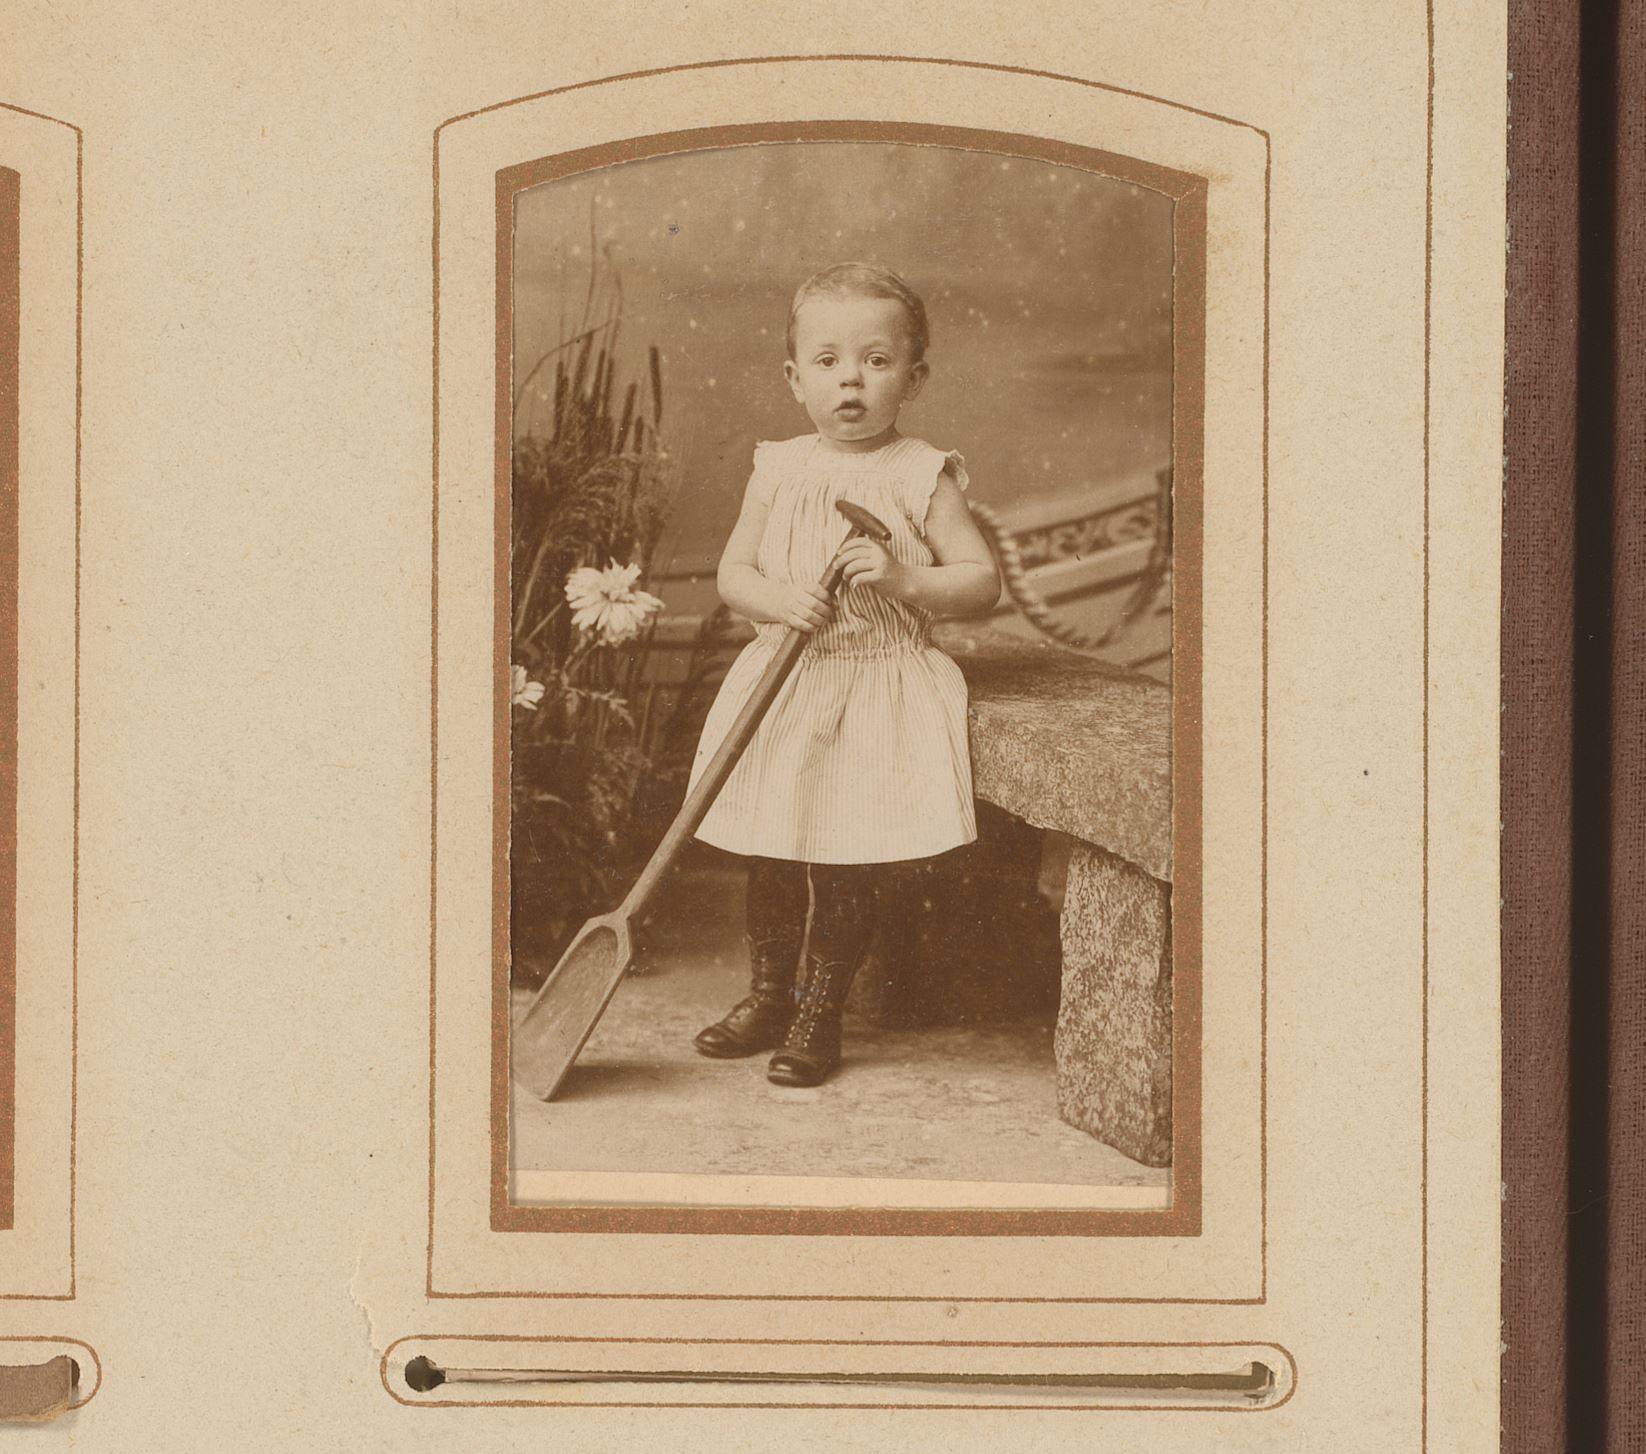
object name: album leaf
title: Portret van een meisje met schep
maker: henricus jacobus tollens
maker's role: painter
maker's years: 1864-1936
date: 1890-1908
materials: cardboard, photographic support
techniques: albumen print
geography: dordrecht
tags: girl (child between toddler and youth)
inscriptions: inscription: ‘H.J. Tollens, C.Hzn./ Fa J.G. Hameter (...) Dordrecht/ Voorstraat 289’